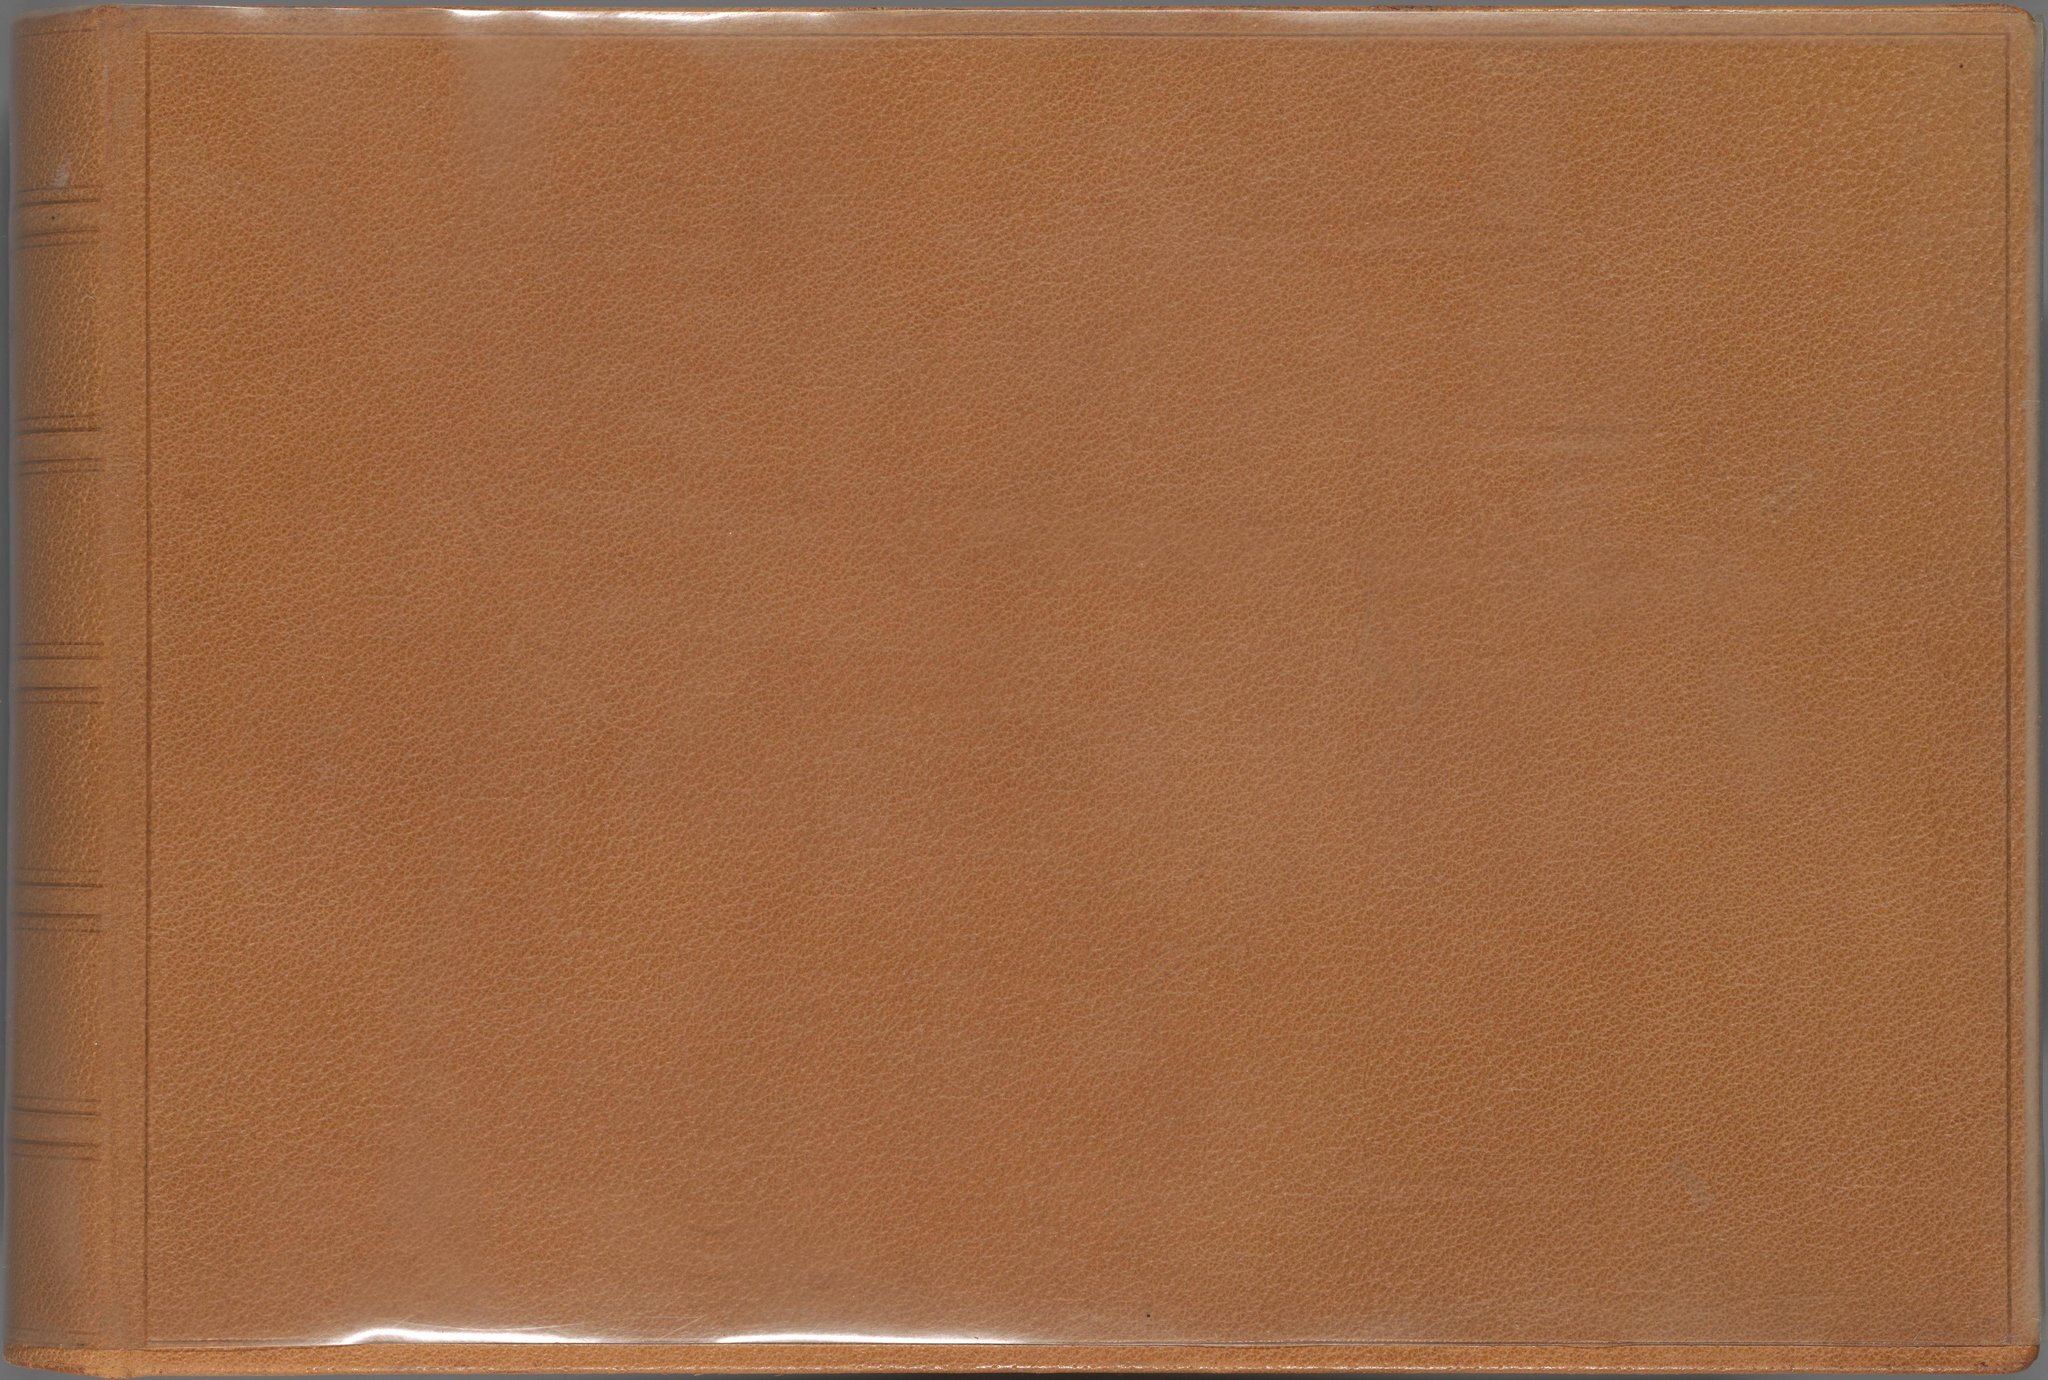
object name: photograph album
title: Commemorative Album of the KLM’s East Indies Route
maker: Anonymous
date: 1949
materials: cardboard, leather, paper, photographic support, plastic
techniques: gelatin silver print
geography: netherlands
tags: leiden, the hague, arnhem, aircraft, aeroplane, airborne traffic, aviation, travelling; tourism, netherlands, dutch east indies, the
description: This album was compiled on the occasion of the thousandth flight of the KLM’s East Indies route after World War II. Featured in the photograph is the famous ‘Uiver,’ the KLM aeroplane that won the handicap section in the 1934 London-Melbourne air race. With its aluminum construction, this Douglas DC-2 belonged to the latest generation of aircraft of its day.